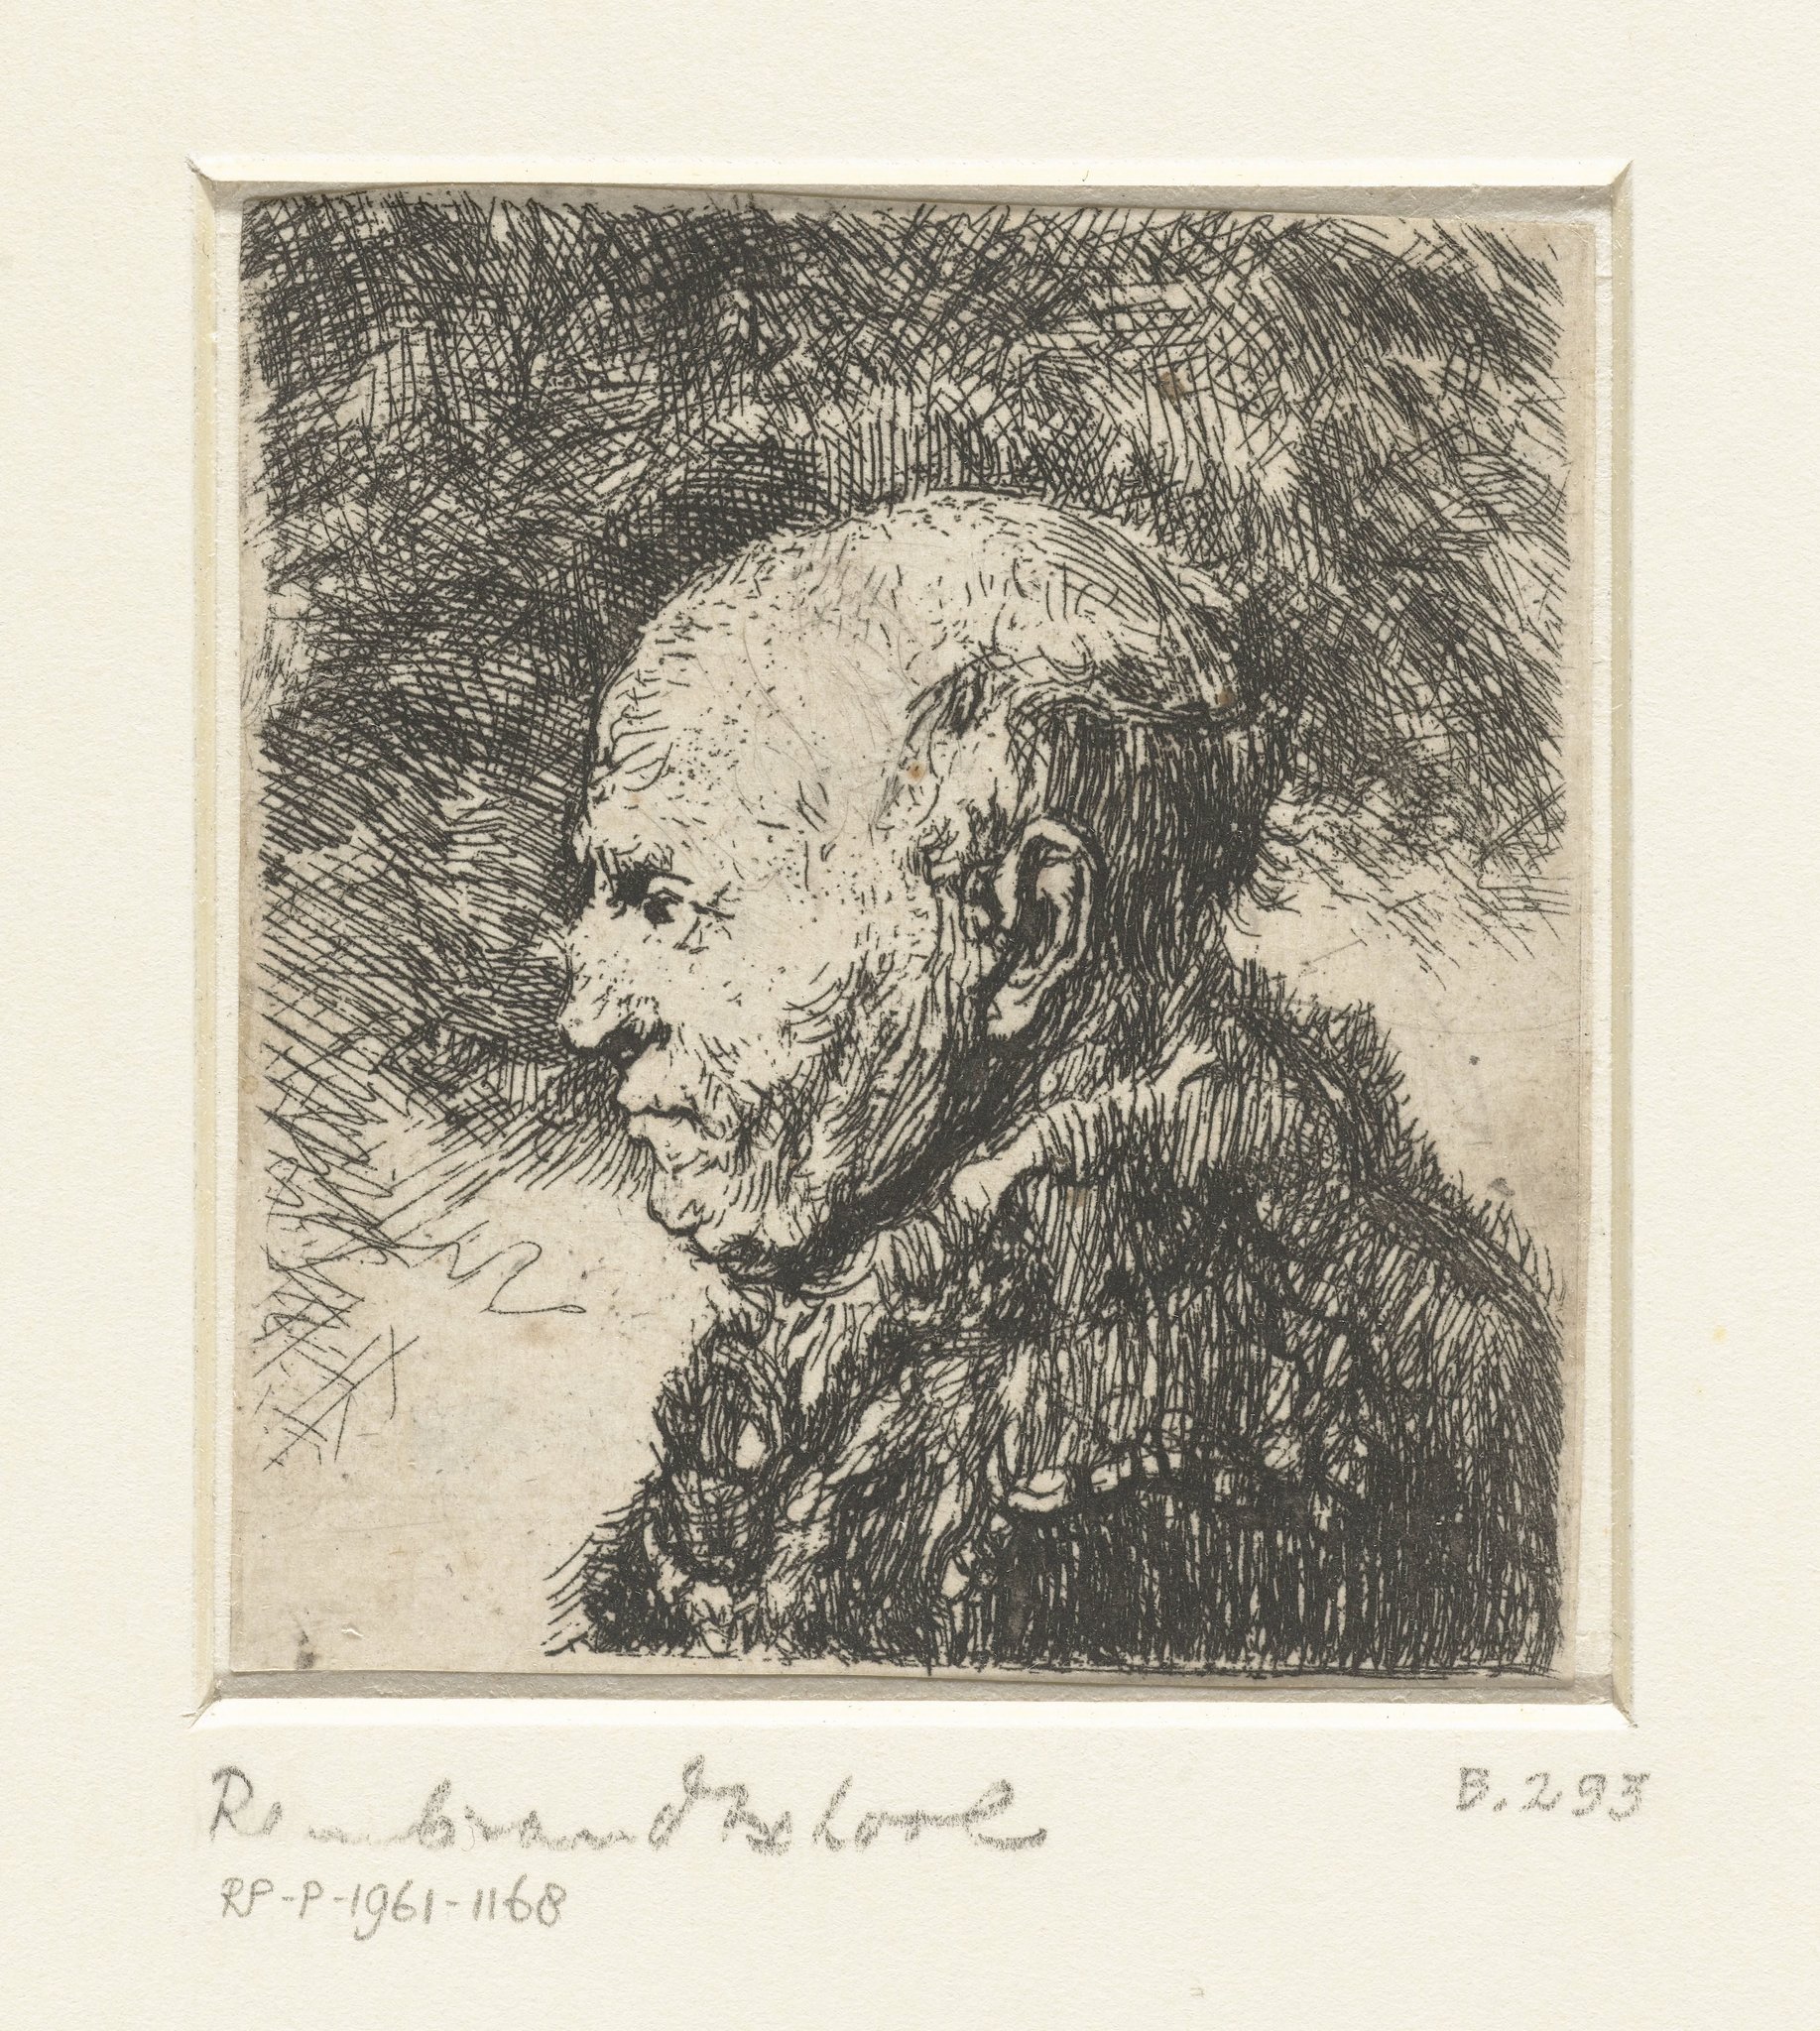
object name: print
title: Buste van kale oude man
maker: Anonymous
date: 1630-1700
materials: paper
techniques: etching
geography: netherlands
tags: old man (+ sideview, profile)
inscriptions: inscription: ‘Zott e y.59 (?)’, collector's mark: ‘G’ Lugt 1169bis, collector's mark: Lugt 2228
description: Kopie naar de gelijknamige prent van Rembrandt (Bar 292). Derde staat van drie (Münz 1952), zou ook eerste staat kunnen zijn. Botke, K.